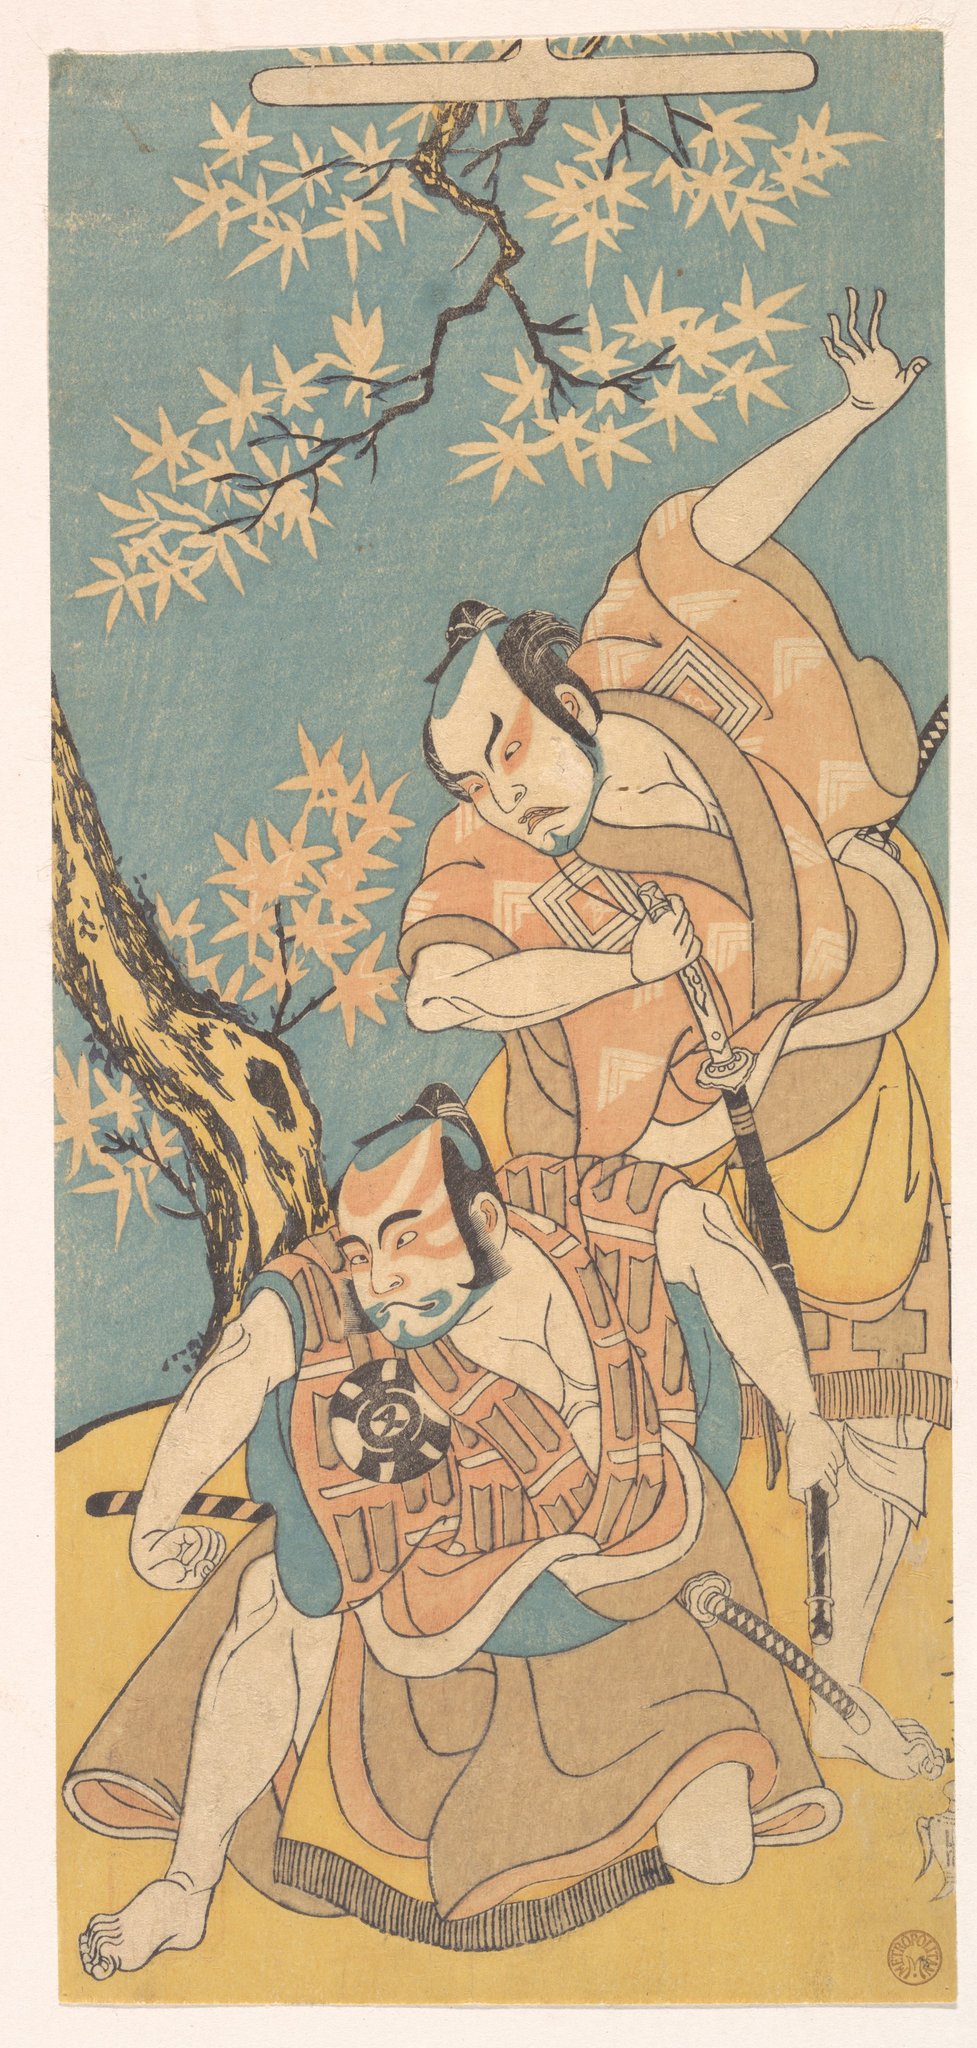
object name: woodblock print nishiki e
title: Scene From The Drama "Otokoyama Yunzei Kurabe"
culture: japanese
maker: katsukawa shunshō 勝川春章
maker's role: artist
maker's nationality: japanese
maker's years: 1726-1792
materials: ink, paper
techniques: nishiki e, woodblock print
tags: swords,men,trees,actors